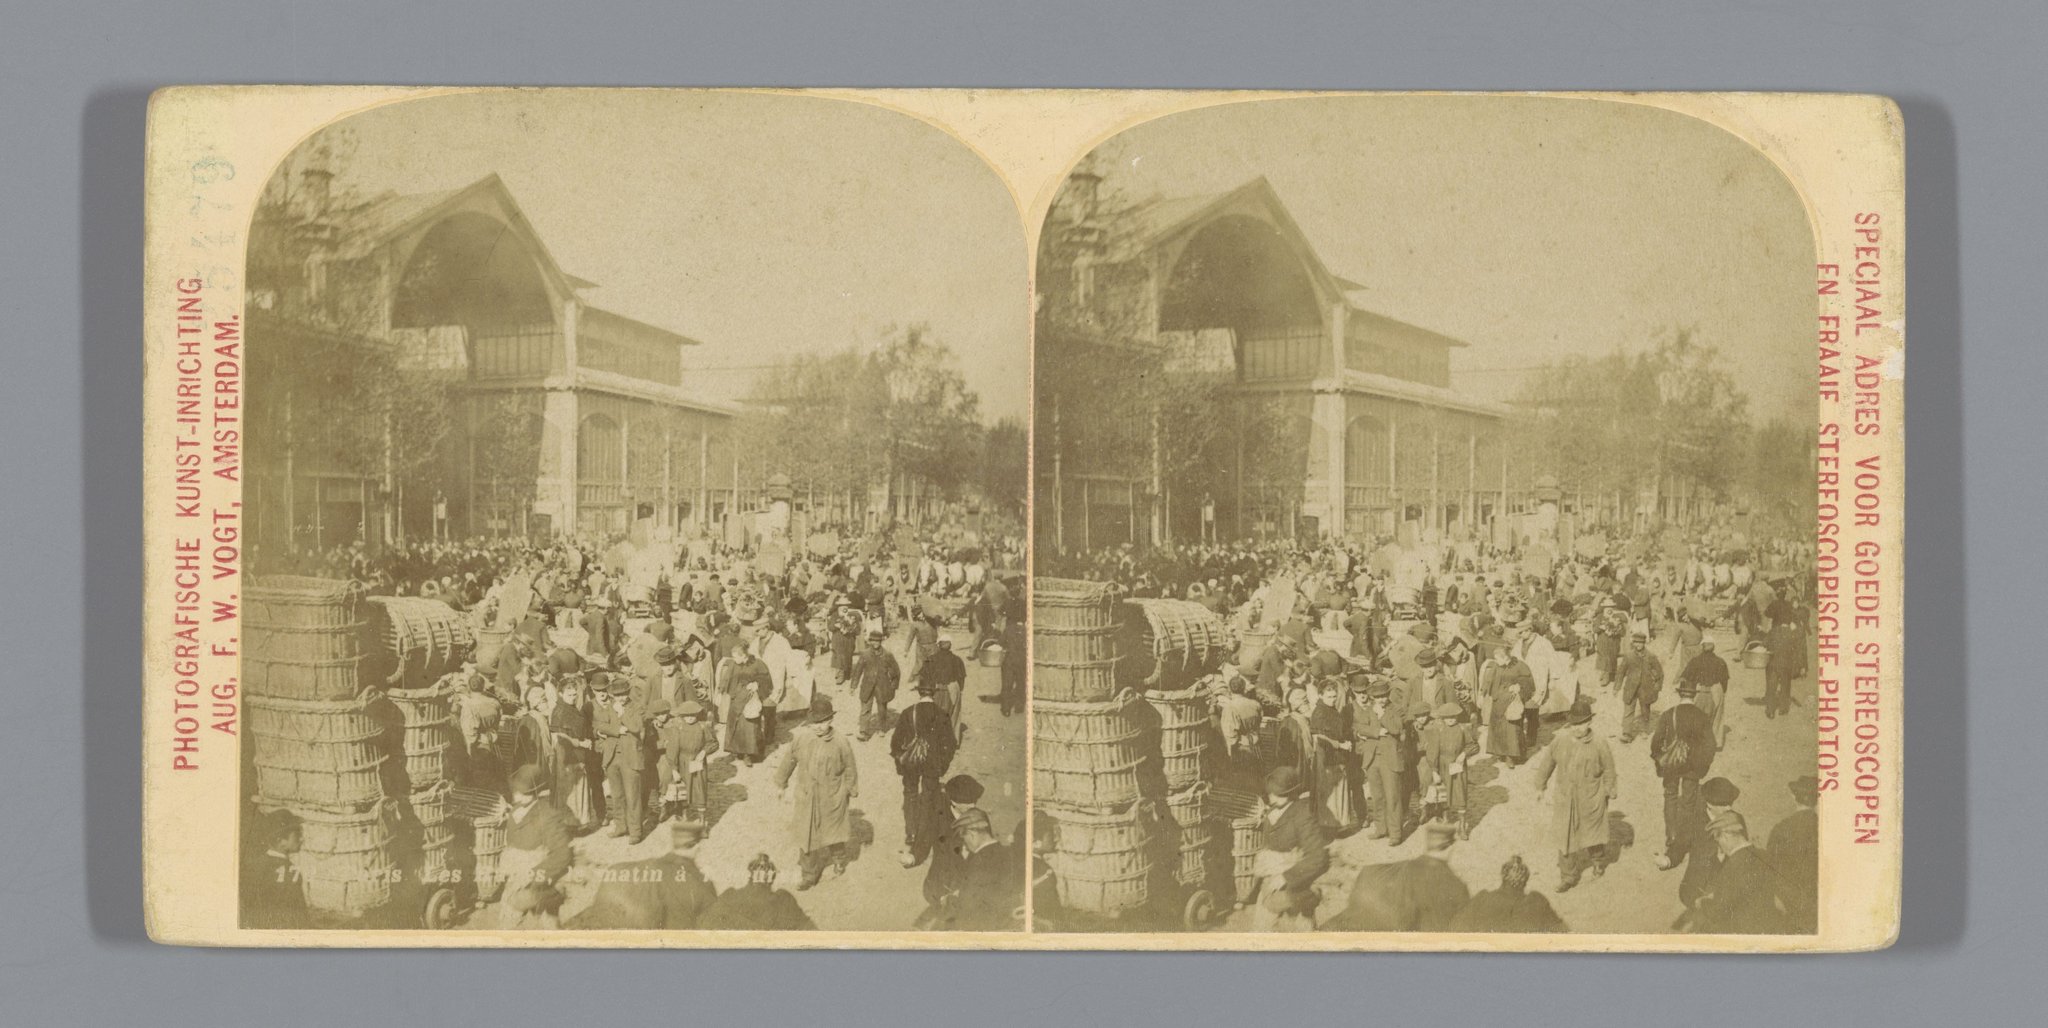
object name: stereograph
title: Gezicht op een menigte bij Les Halles te Parijs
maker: august frederik willem vogt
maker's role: fotograaf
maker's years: 1871-1922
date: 1875-1895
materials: cardboard, photographic support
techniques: albumen print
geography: paris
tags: market-hall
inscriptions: number: ‘25479’, inscription: ‘Speciaal adres voor goede stereoscopen en fraaie stereoscopische-photo's. photographische kunst-inrichting Aug. F. W. Vogt, Amsterdam.’, number: ‘170’